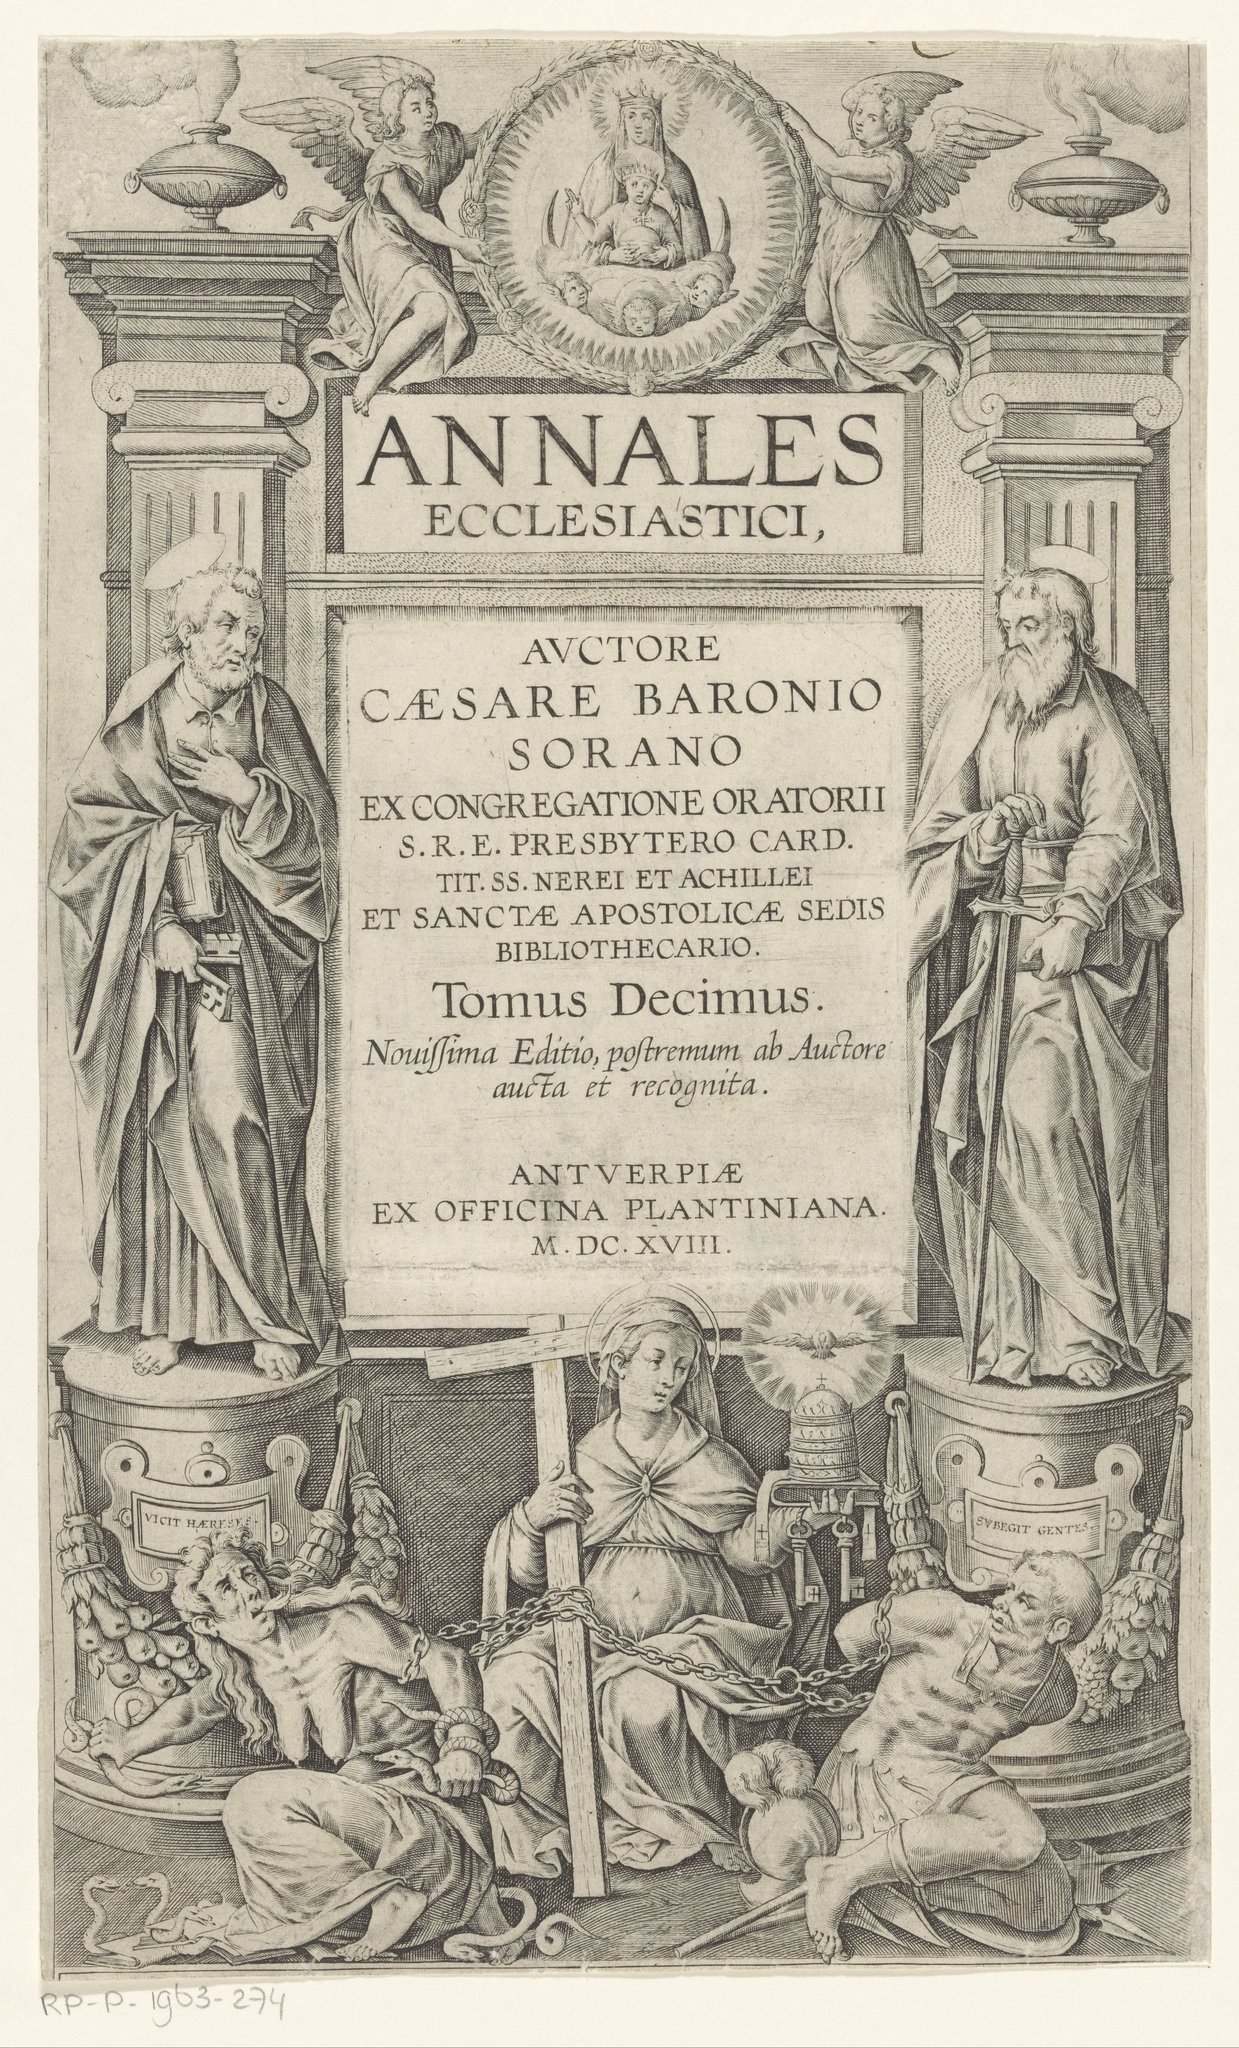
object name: titelblad, titelpagina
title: Titelpagina voor: Caesar Baronius, Annales Ecclesiastici, 1618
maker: Anonymous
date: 1618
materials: paper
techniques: engraving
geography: antwerp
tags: allegorical and symbolical representations ~ the church and religion, error; 'errore' (ripa), heresy; 'heresia' (ripa), the apostle peter, first bishop of rome; possible attributes: book, cock, (upturned) cross, (triple) crozier, fish, key, scroll, ship, tiara, the apostle paul of tarsus; possible attributes: book, scroll, sword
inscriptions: collector's mark: Lugt 2228, collector's mark: Lugt 2760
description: Petrus met twee sleutels en Paulus met een zwaard staan op voetstukken voor pilasters aan weerszijden van de Latijnse titel. Voor hen zit de personificatie van de Katholieke Kerk met een kruis, de pauselijke tiara, een bijbel en sleutels. Naast haar zitten een geketende vrouw met slangen en een geketende soldaat. Aan de bovenzijde twee engelen met een medaillon met gekroonde Maria met Christuskind gezeten op een maan.